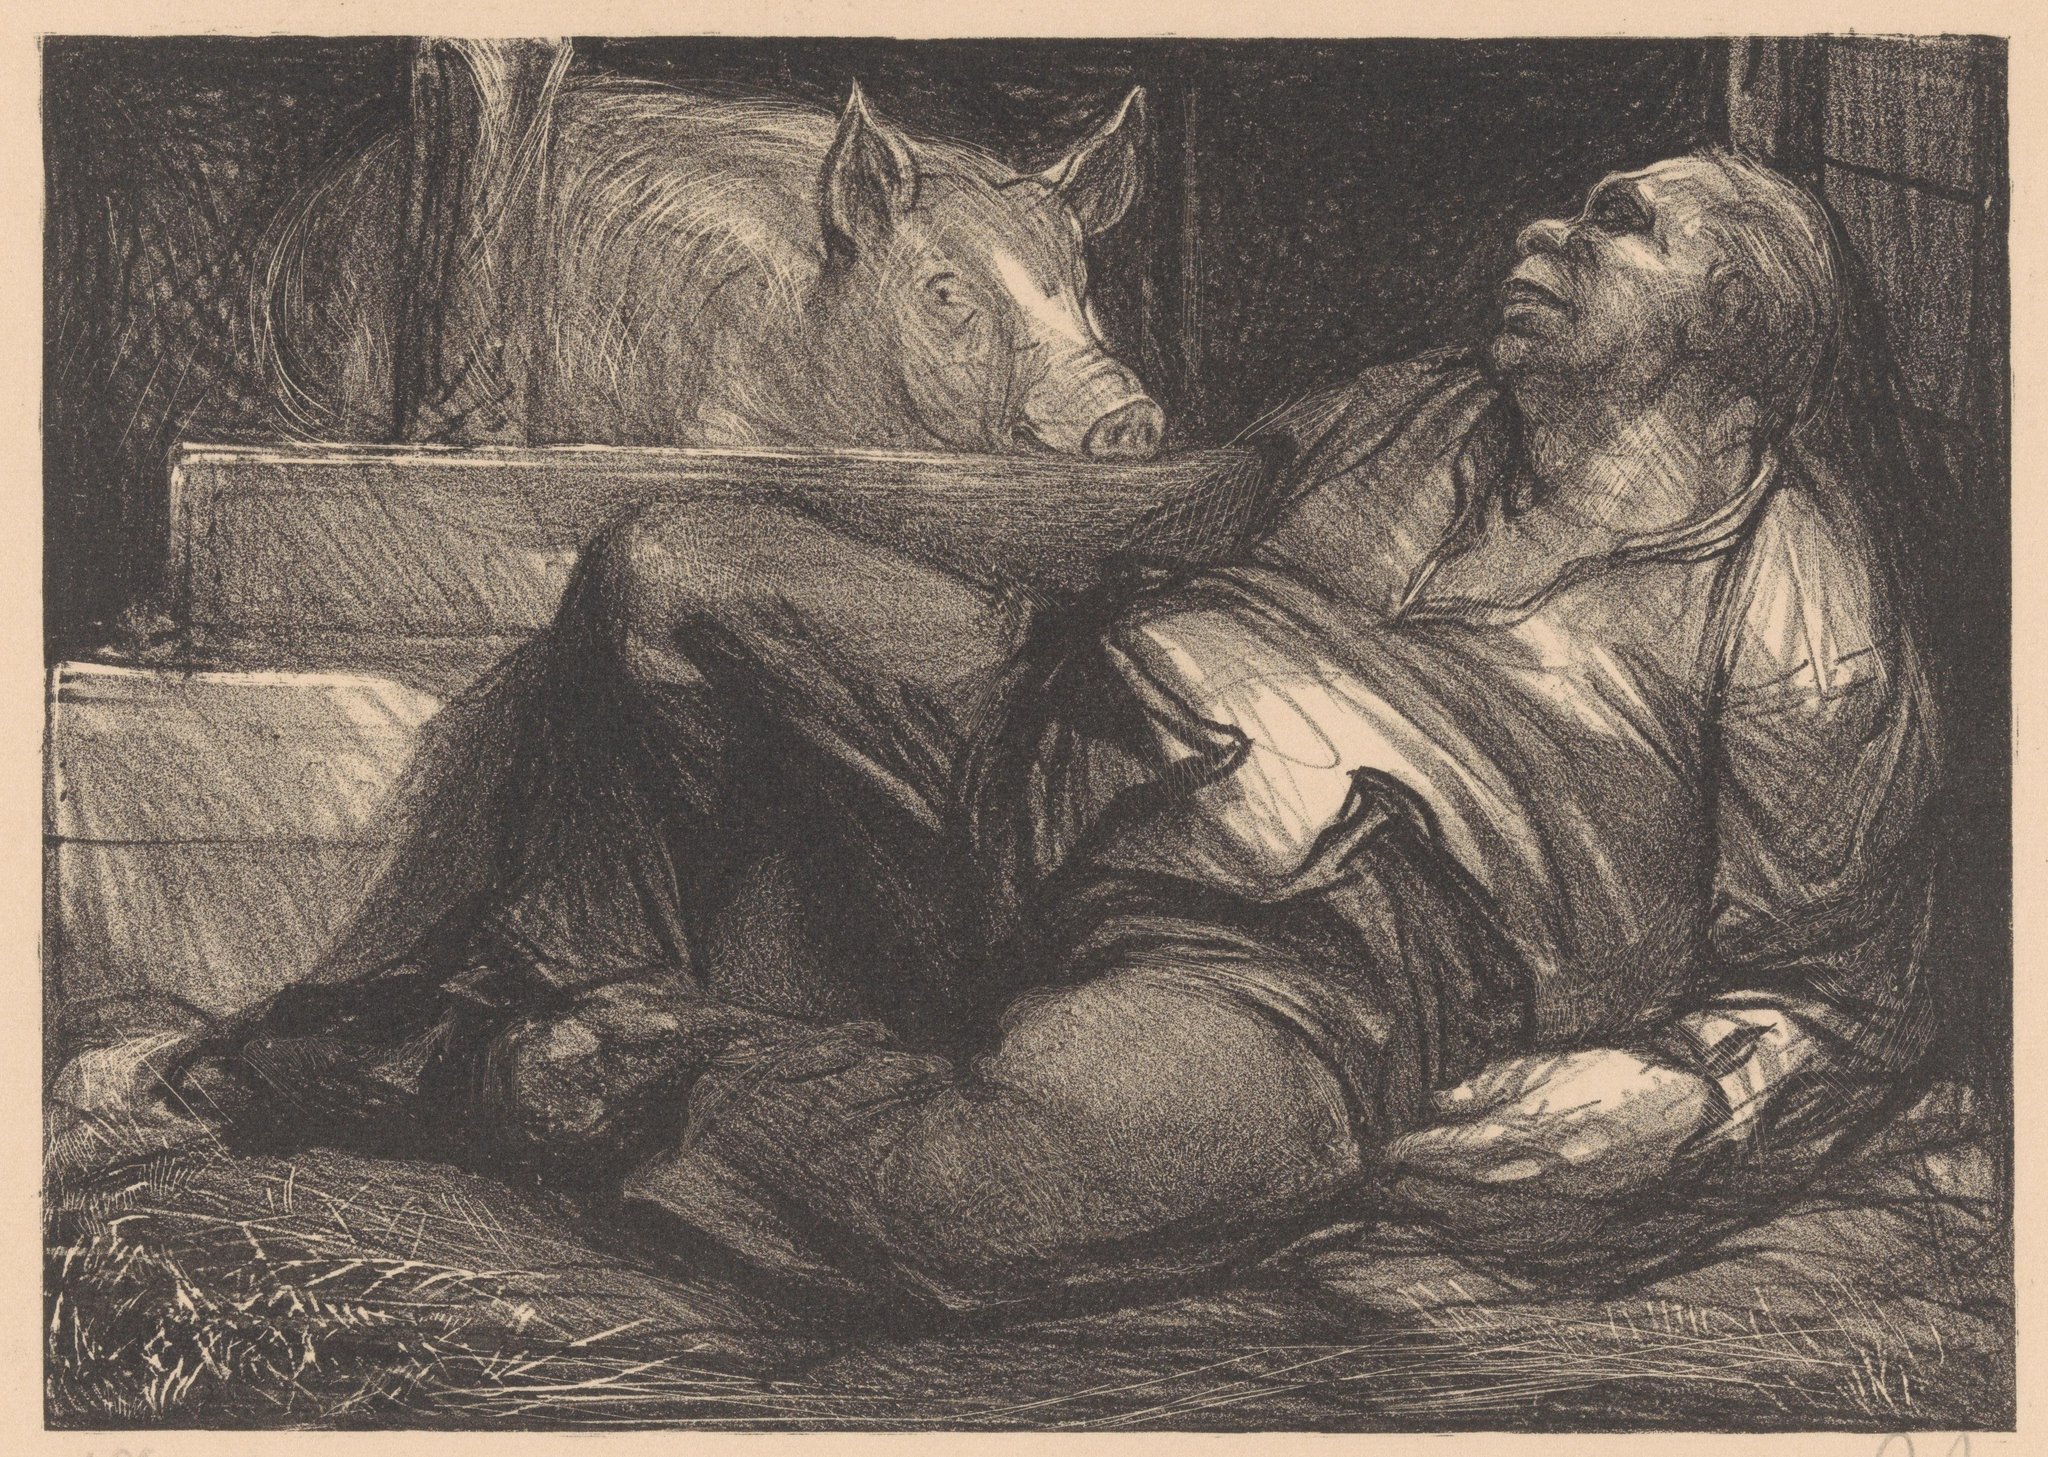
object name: print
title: Slapende varkensboer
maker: johannes josephus aarts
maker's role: draughtsman, print maker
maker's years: 1871-1934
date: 1881-1931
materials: paper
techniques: lithograph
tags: pig, sloth, indolence, 'acedia', 'desidia'; 'accidia' (ripa) ~ personification of one of the seven deadly sins, gluttony, intemperance, 'gula'; 'gola', 'ingordigia', 'ingordigia overo avidità', 'voracità' (ripa) ~ personification of one of the seven deadly sins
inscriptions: collector's mark: Lugt 2228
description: Een dikke, slapende man met geopende broek, in het gezelschap van een varken. Mogelijk een allegorische voorsteling van gulzigheid en luiheid.